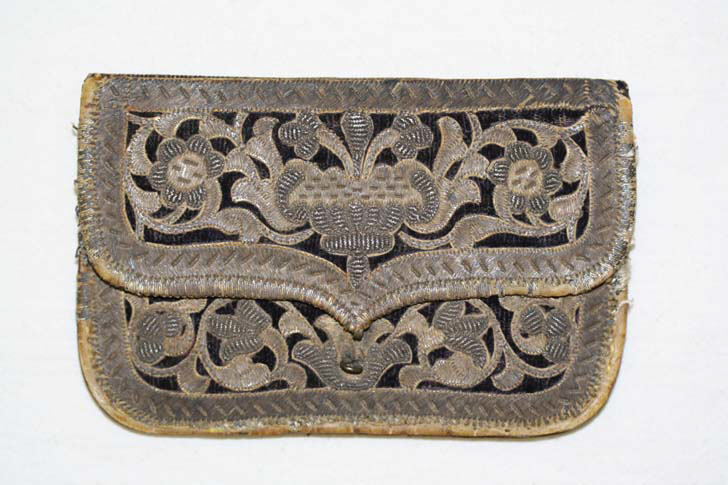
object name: purse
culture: french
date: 1725-1740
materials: leather, metal, silk